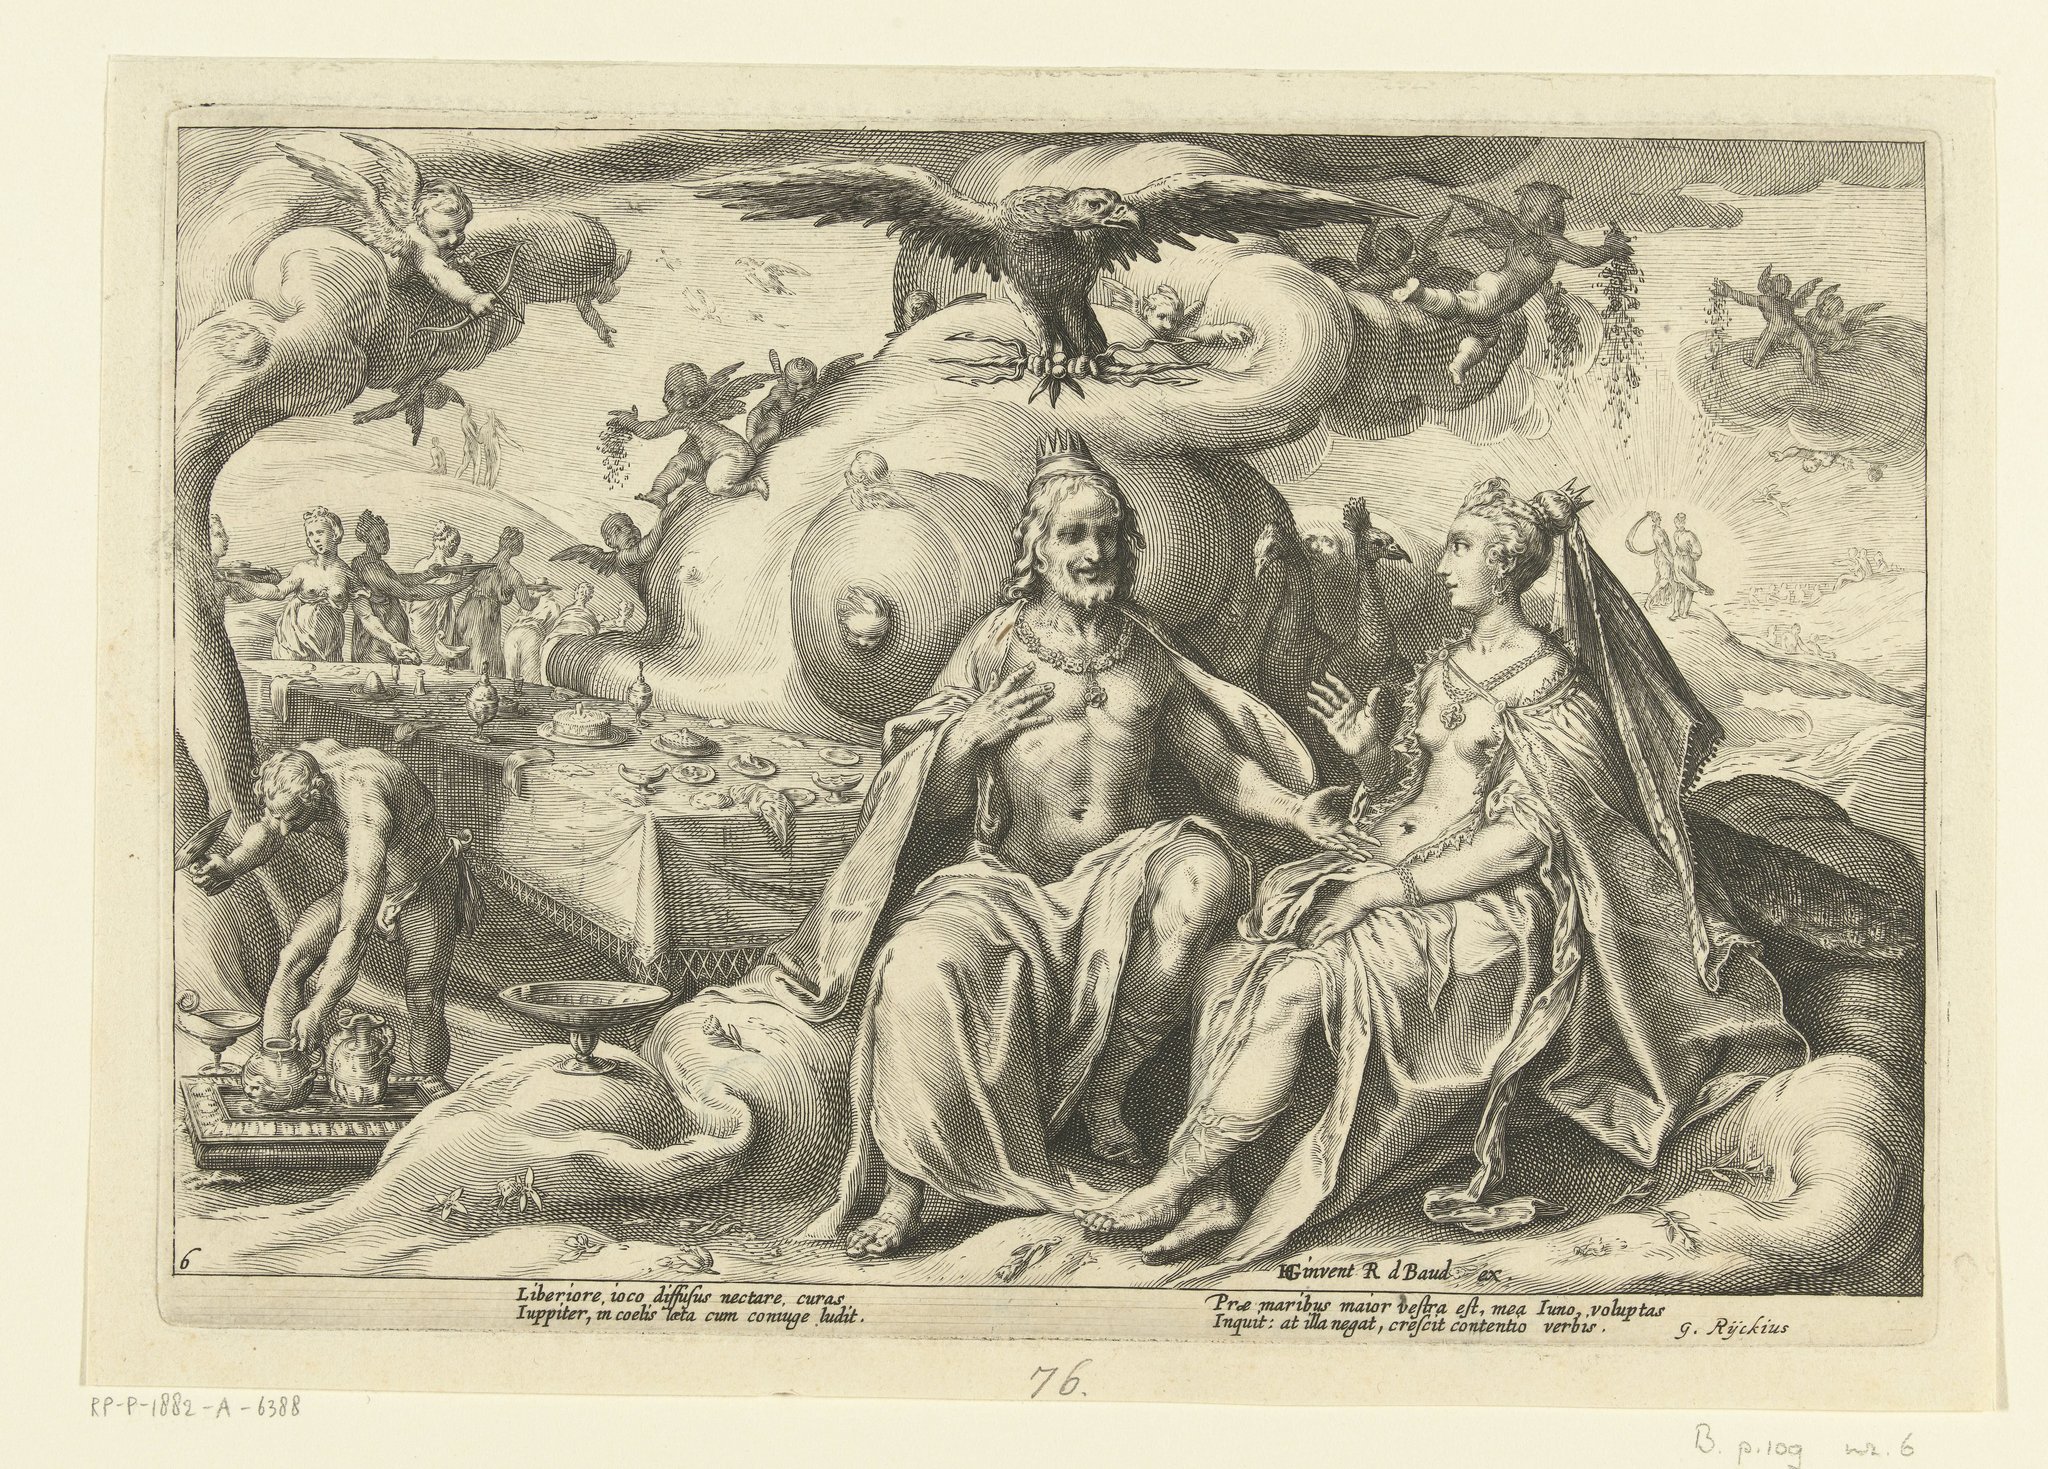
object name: print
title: Jupiter en Juno discussiëren over de vraag bij welke van de seksen de lust in liefde groter is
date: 1615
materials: paper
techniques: engraving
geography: netherlands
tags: (story of) juno (hera), (story of) jupiter (zeus)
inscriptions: collector's mark: Lugt 1606, collector's mark: Lugt 2398, collector's mark: Lugt 2510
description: Jupiter en Juno zitten naast elkaar, voor een lange tafel die juist wordt afgeruimd, en discussiëren over de vraag welke van de seksen het grootste genot kan ervaren in de liefde. Jupiter stelt dat dat het voorrecht van de vrouw is, Juno spreekt hem tegen. Onder de voorstelling twee keer twee regels Latijnse tekst. Deze prent is onderdeel van een serie van 52 prenten die verhalen uit Ovidius' Metamorfosen verbeelden. Deze serie valt uiteen in drie genummerde reeksen: twee van 20 prenten en één van 12 prenten. Deze prent behoort tot de derde reeks.